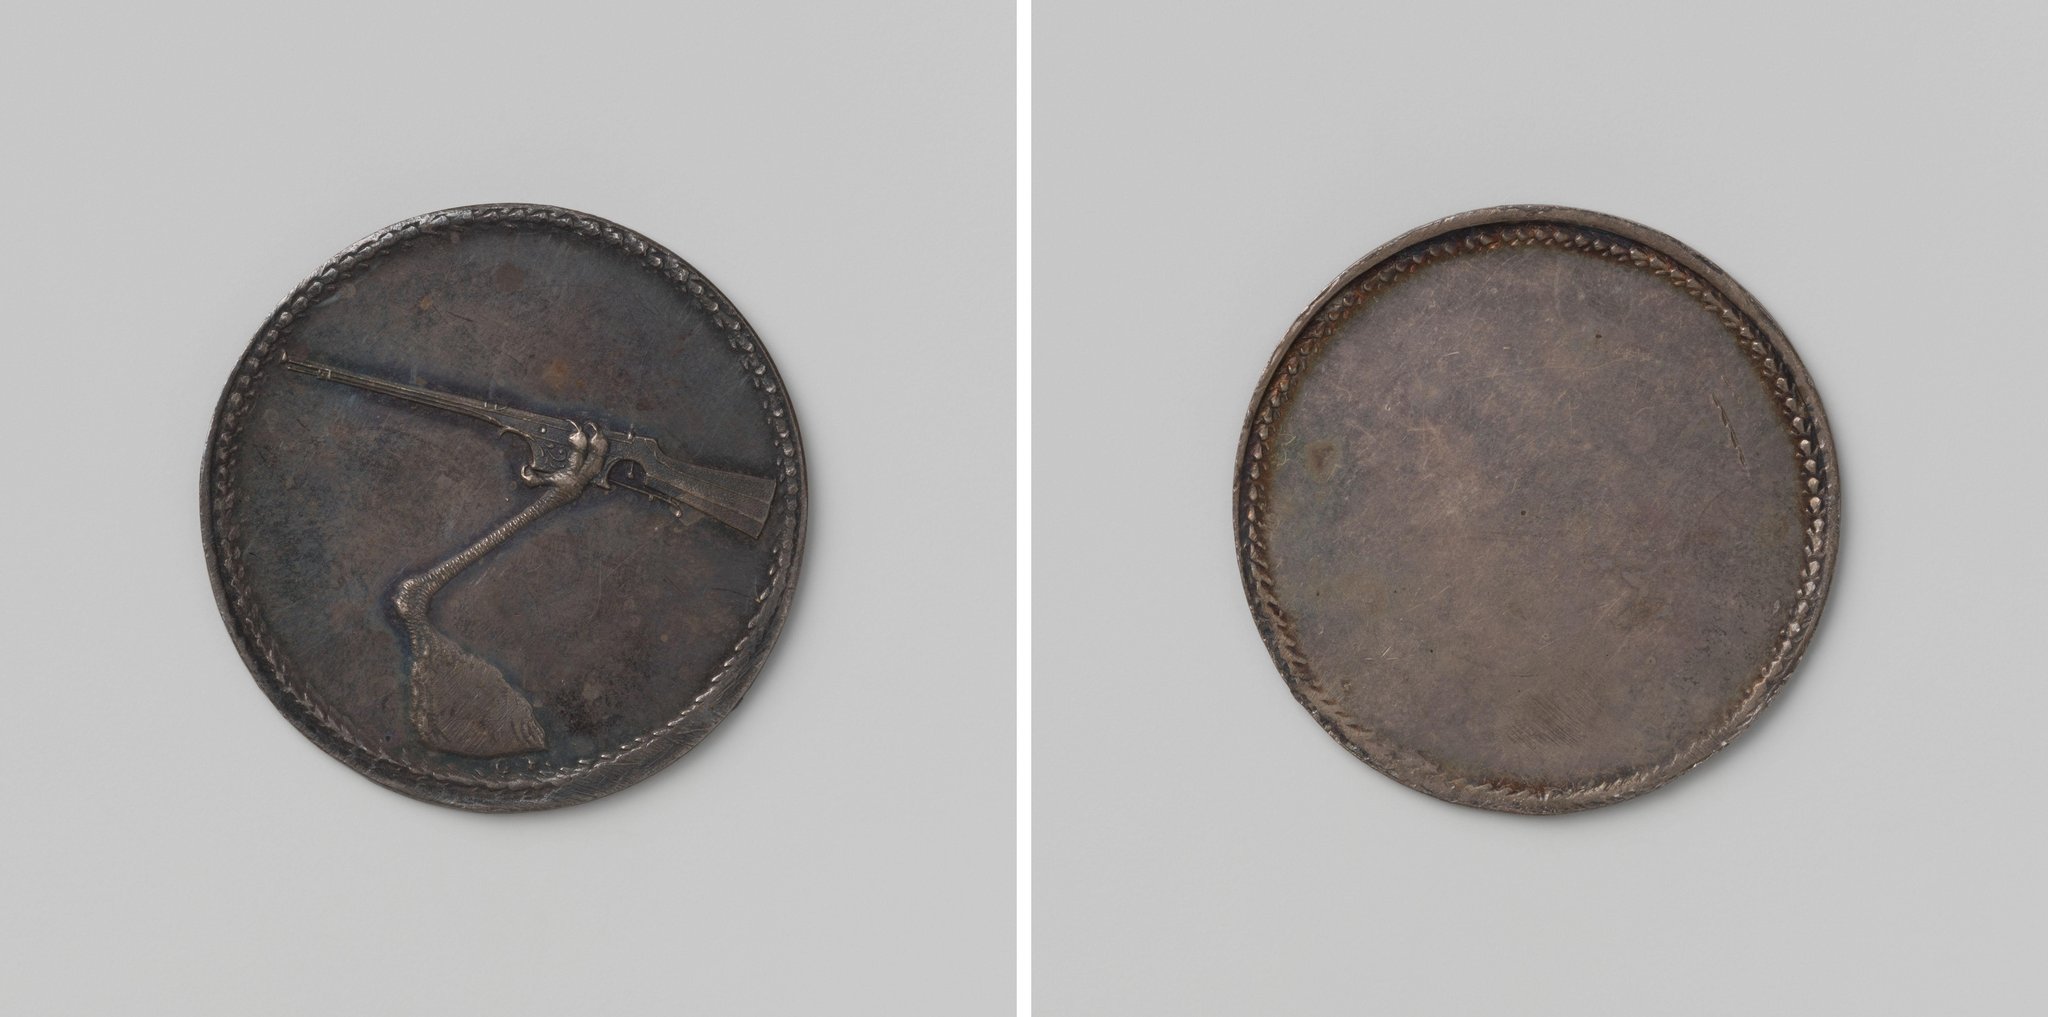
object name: marksman medal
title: Kloveniersgilde van onbekende plaats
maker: Anonymous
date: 1600-1800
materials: silver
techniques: striking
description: Zilveren penning. Voorzijde: vogelklauw die haakbus vasthoudt. Keerzijde: blanco veld.